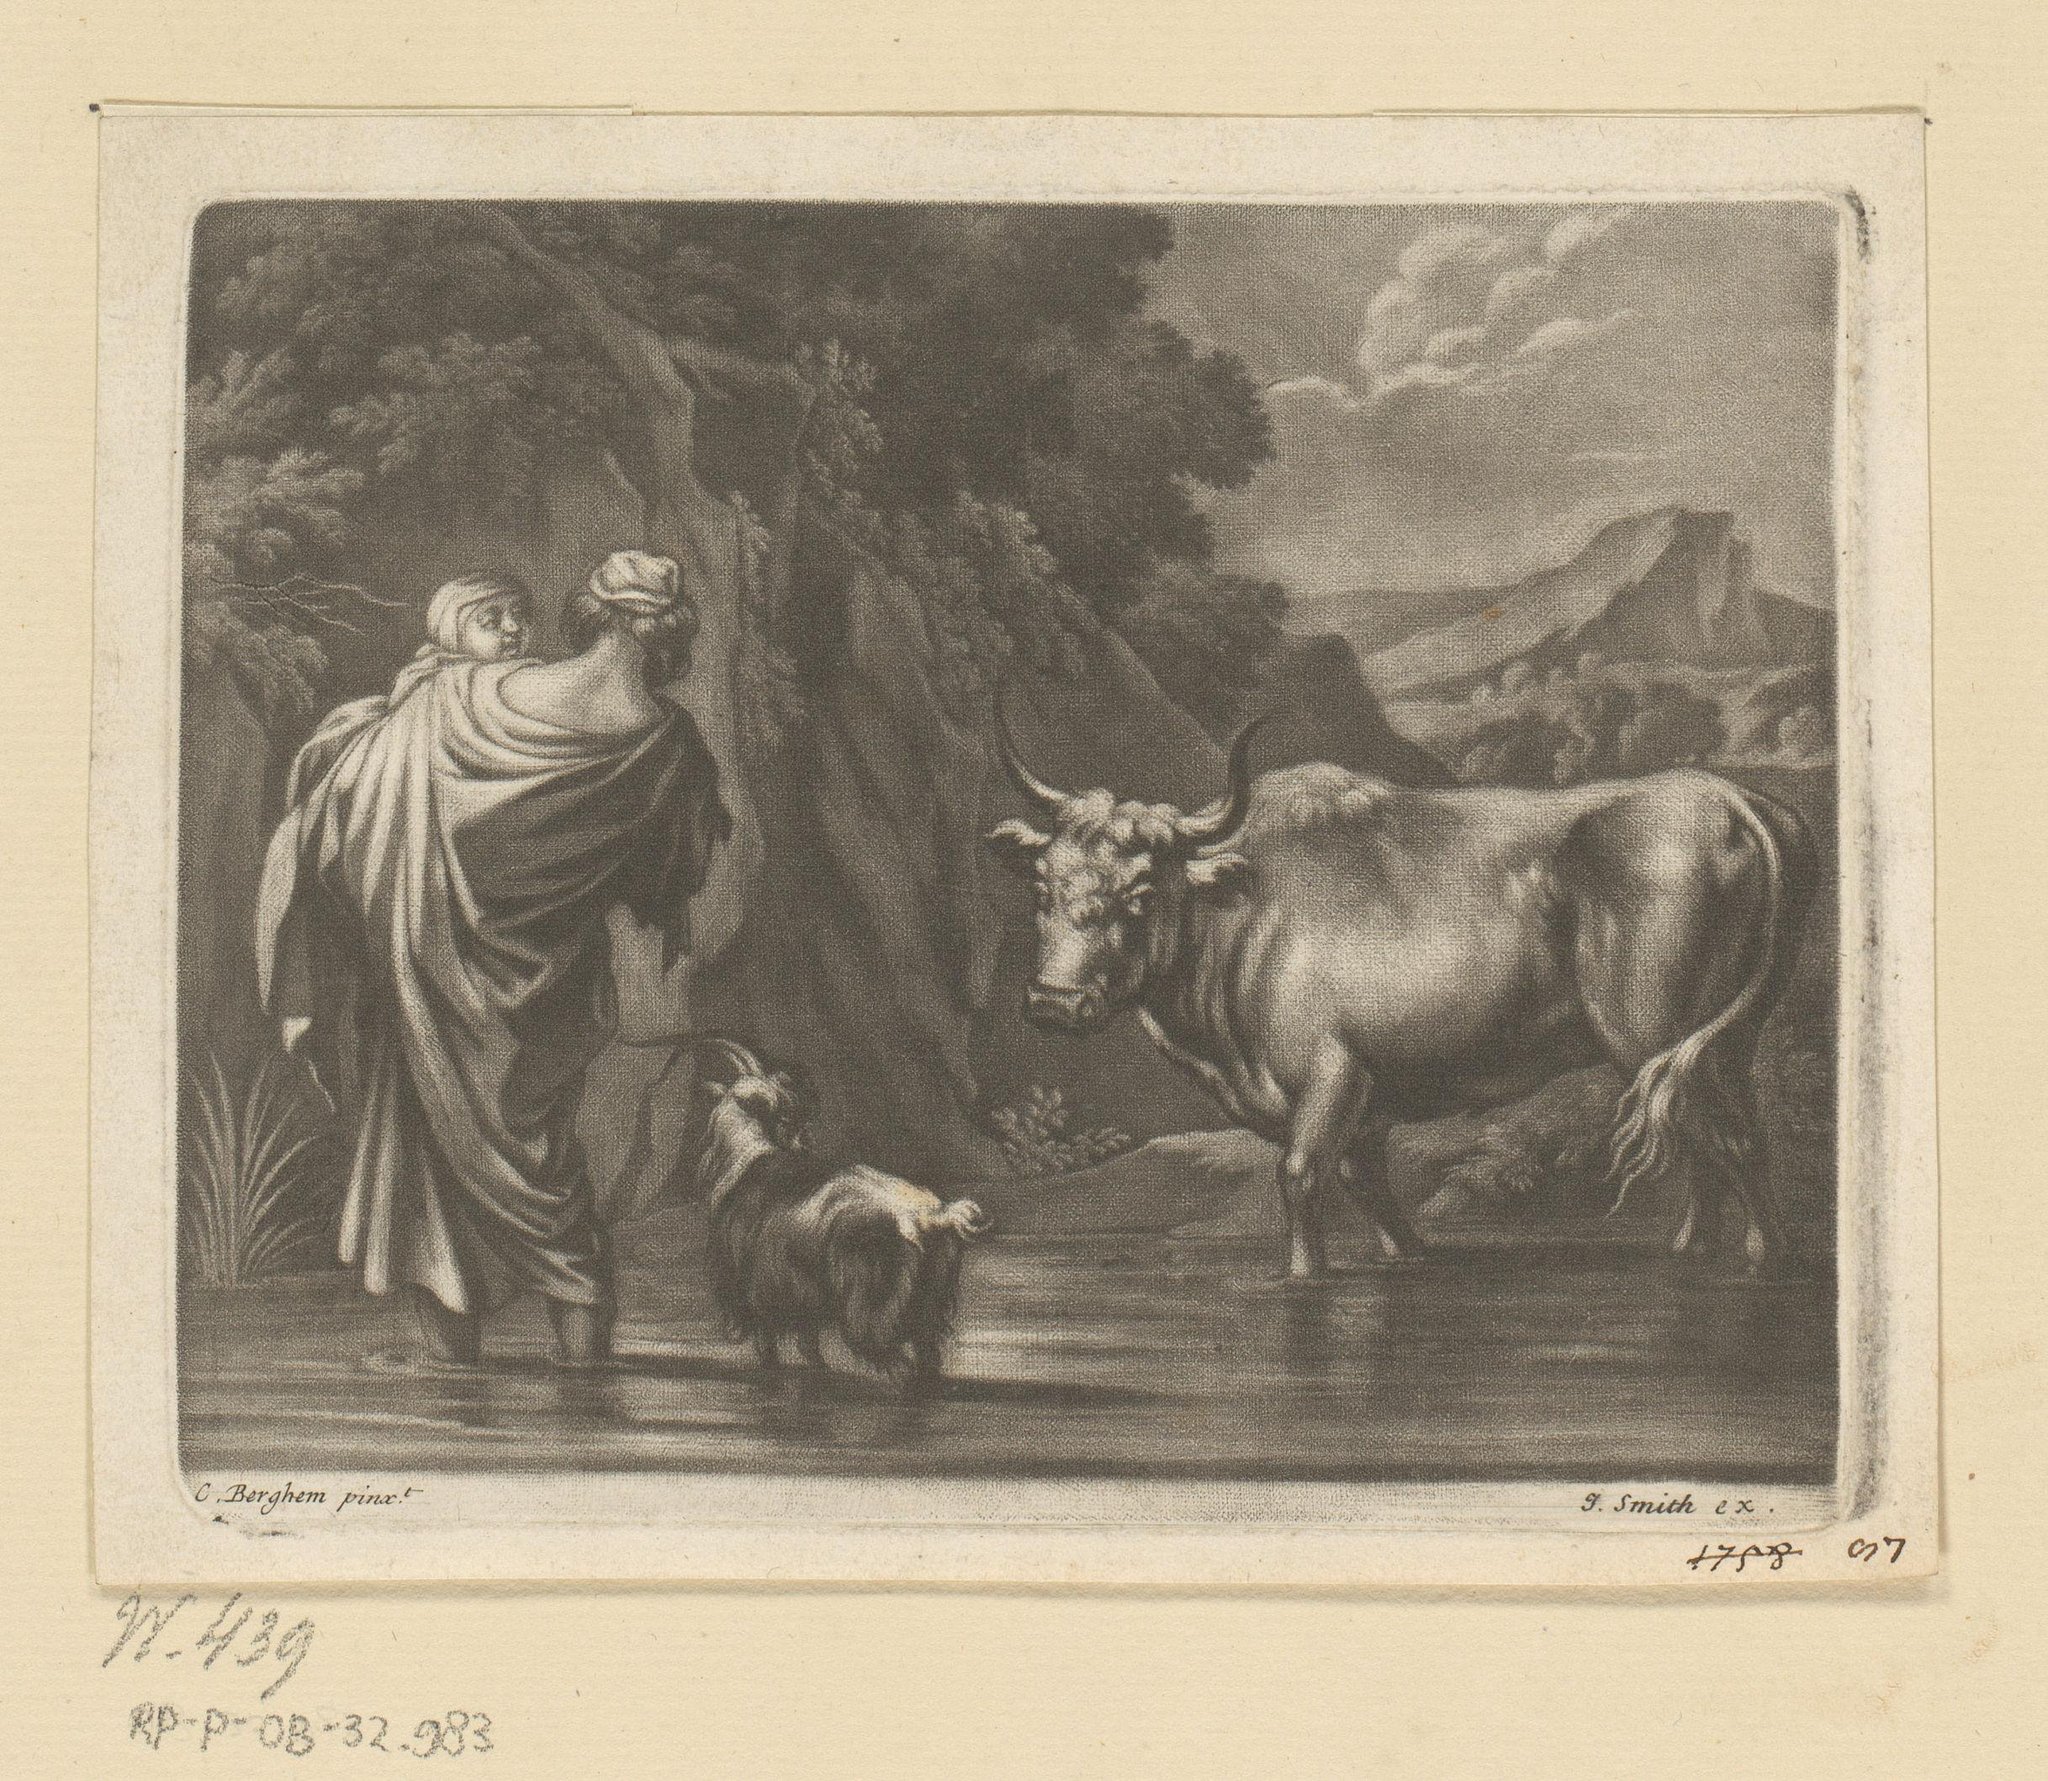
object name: print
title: Herderin met kind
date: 1662-1742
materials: paper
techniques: mezzotint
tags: herding, herdsman, herdswoman, shepherd, shepherdess, cowherd, etc., cattle, 'en route', traveller under way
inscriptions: collector's mark: Lugt 240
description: Ze waden door een rivier met een os en geit.